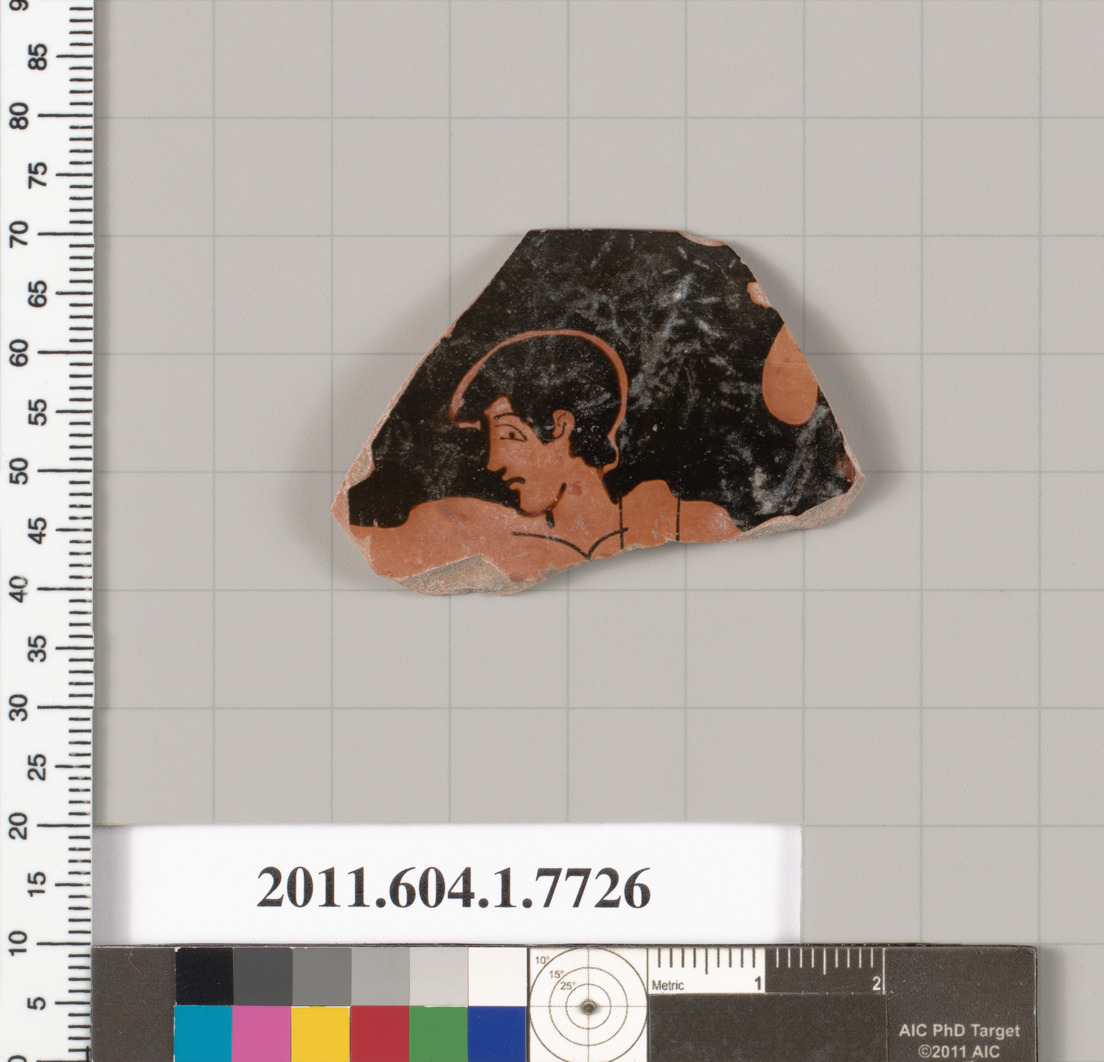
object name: kylix fragment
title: Terracotta rim fragment of a kylix (drinking cup)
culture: greek, attic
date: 460-450 BCE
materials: terracotta